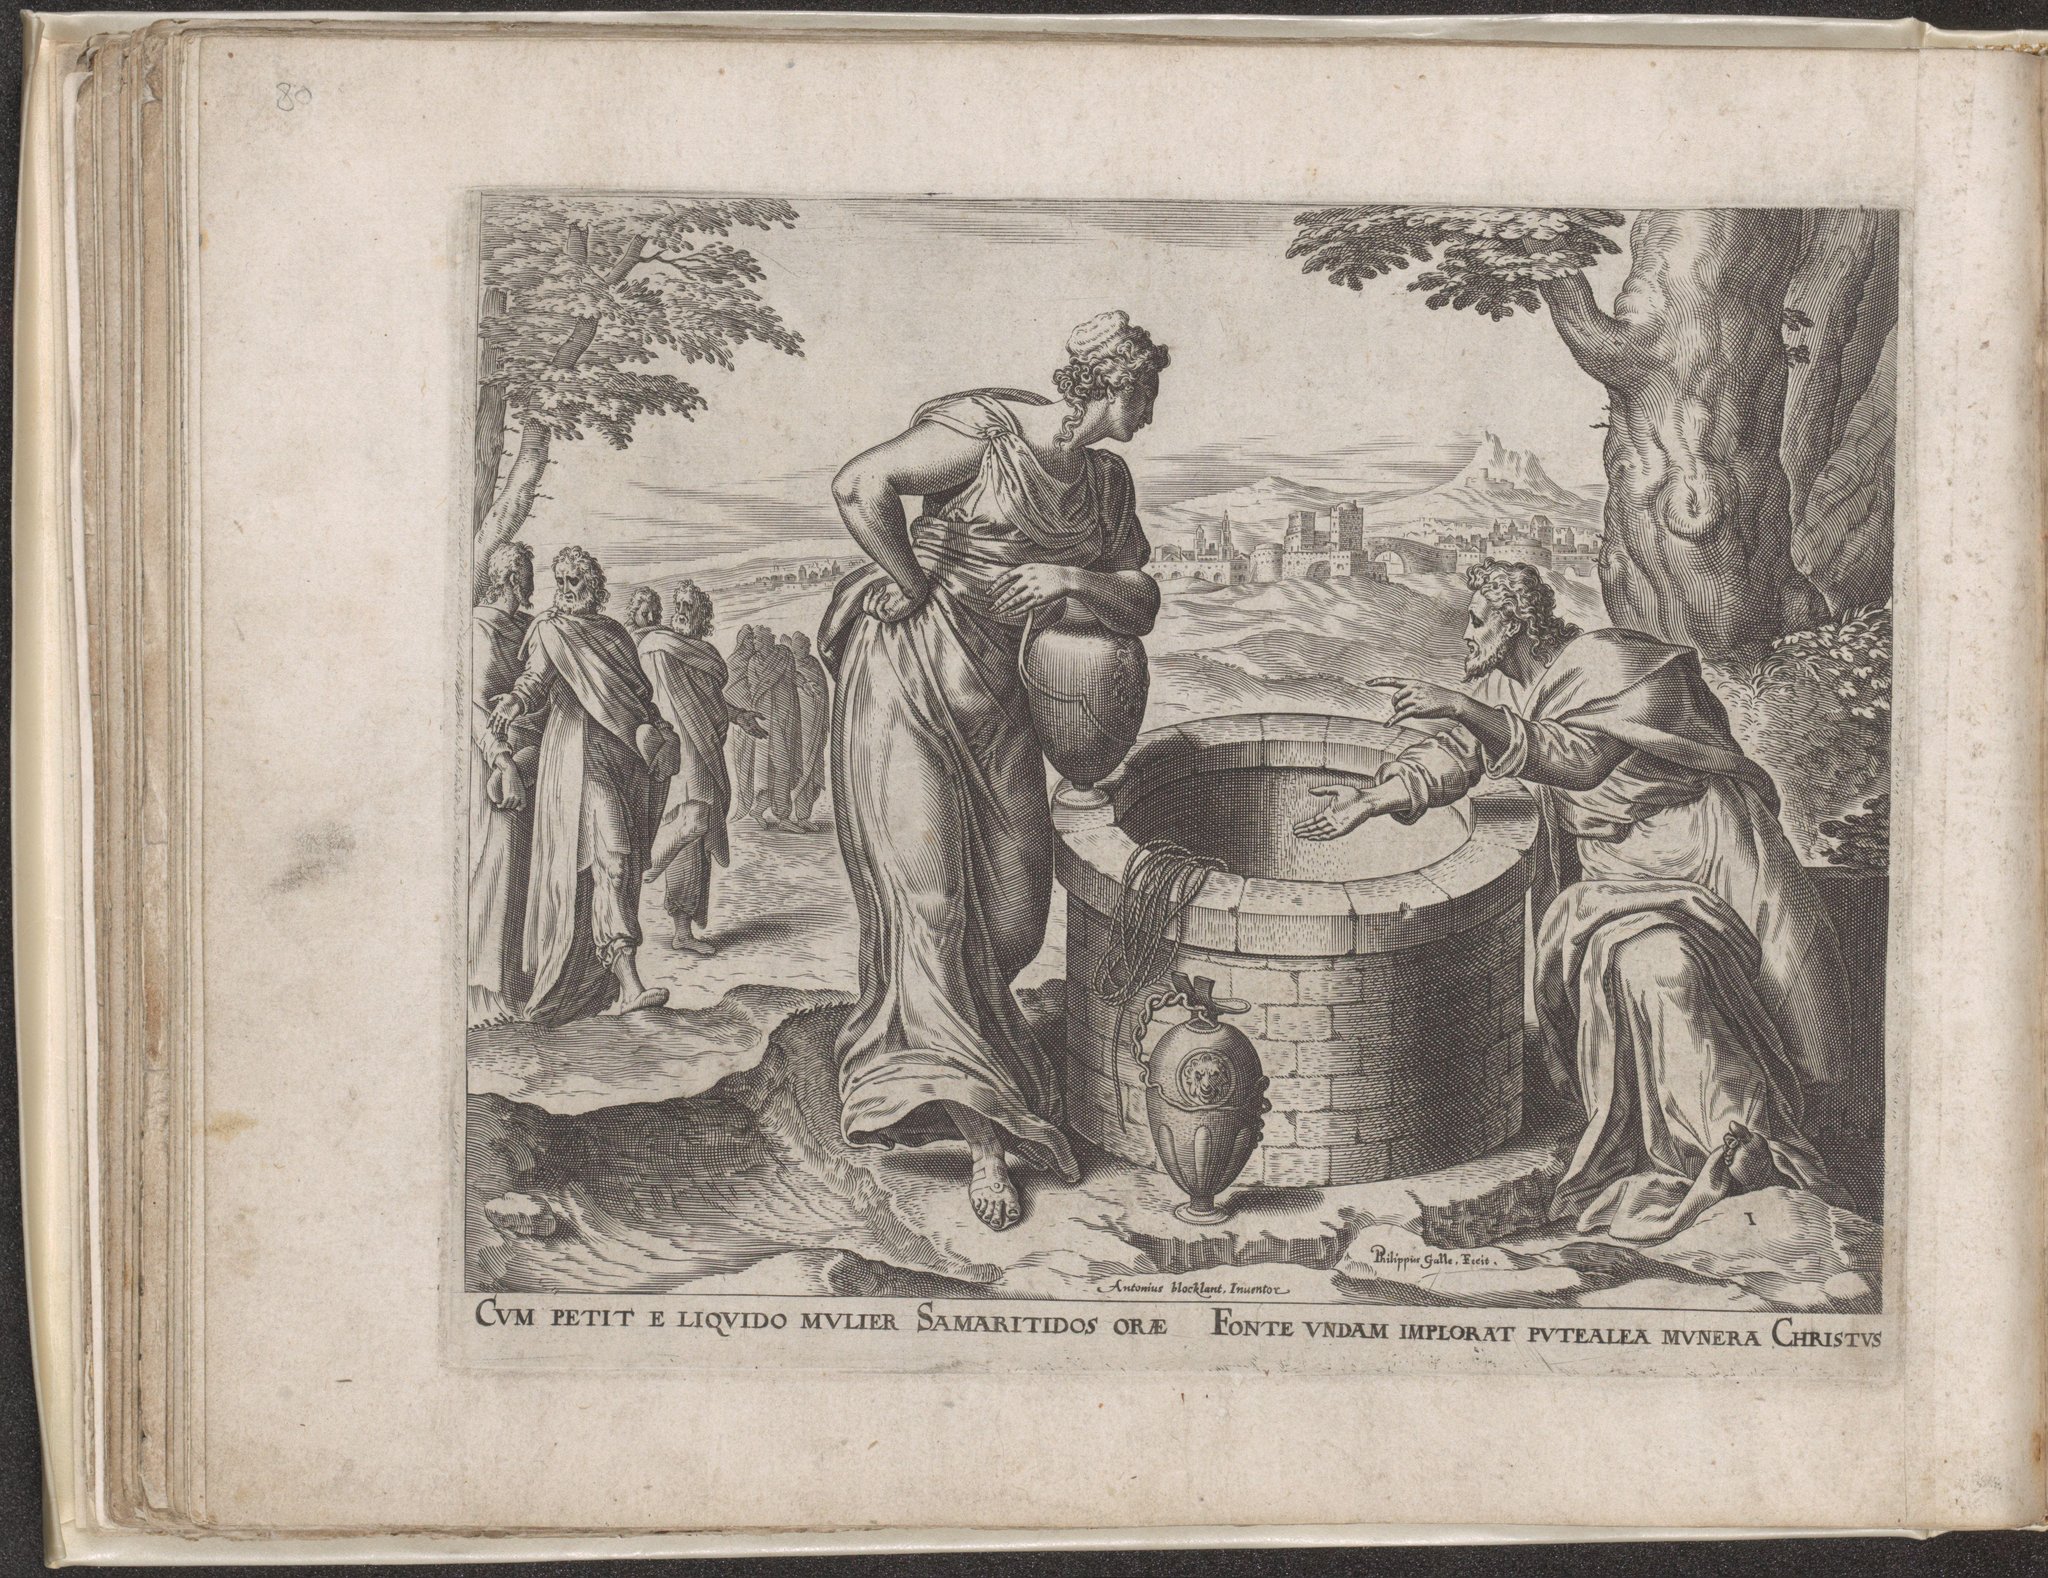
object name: print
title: Zes scènes met Christus en vrouwen uit de evangeliën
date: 1575-1581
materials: paper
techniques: engraving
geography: antwerp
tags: christ and the woman of samaria: sitting at jacob's well he asks her for a drink from her jug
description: Christus rust bij de Jakobsbron, nadat hij zijn discipelen naar de stad heeft gestuurd. Links vertrekken zij richting de stad. Een Samaritaanse vrouw komt om water te putten en spreekt met Christus. Onder de voorstelling een verwijzing in het Latijn naar de Bijbeltekst. Deze prent maakt deel uit van een album.